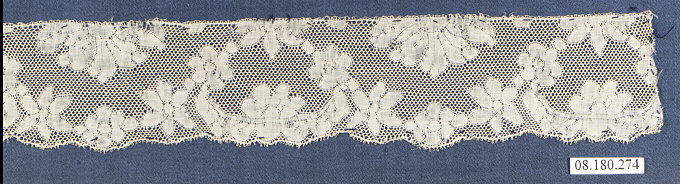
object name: fragment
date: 1701-1800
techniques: lace